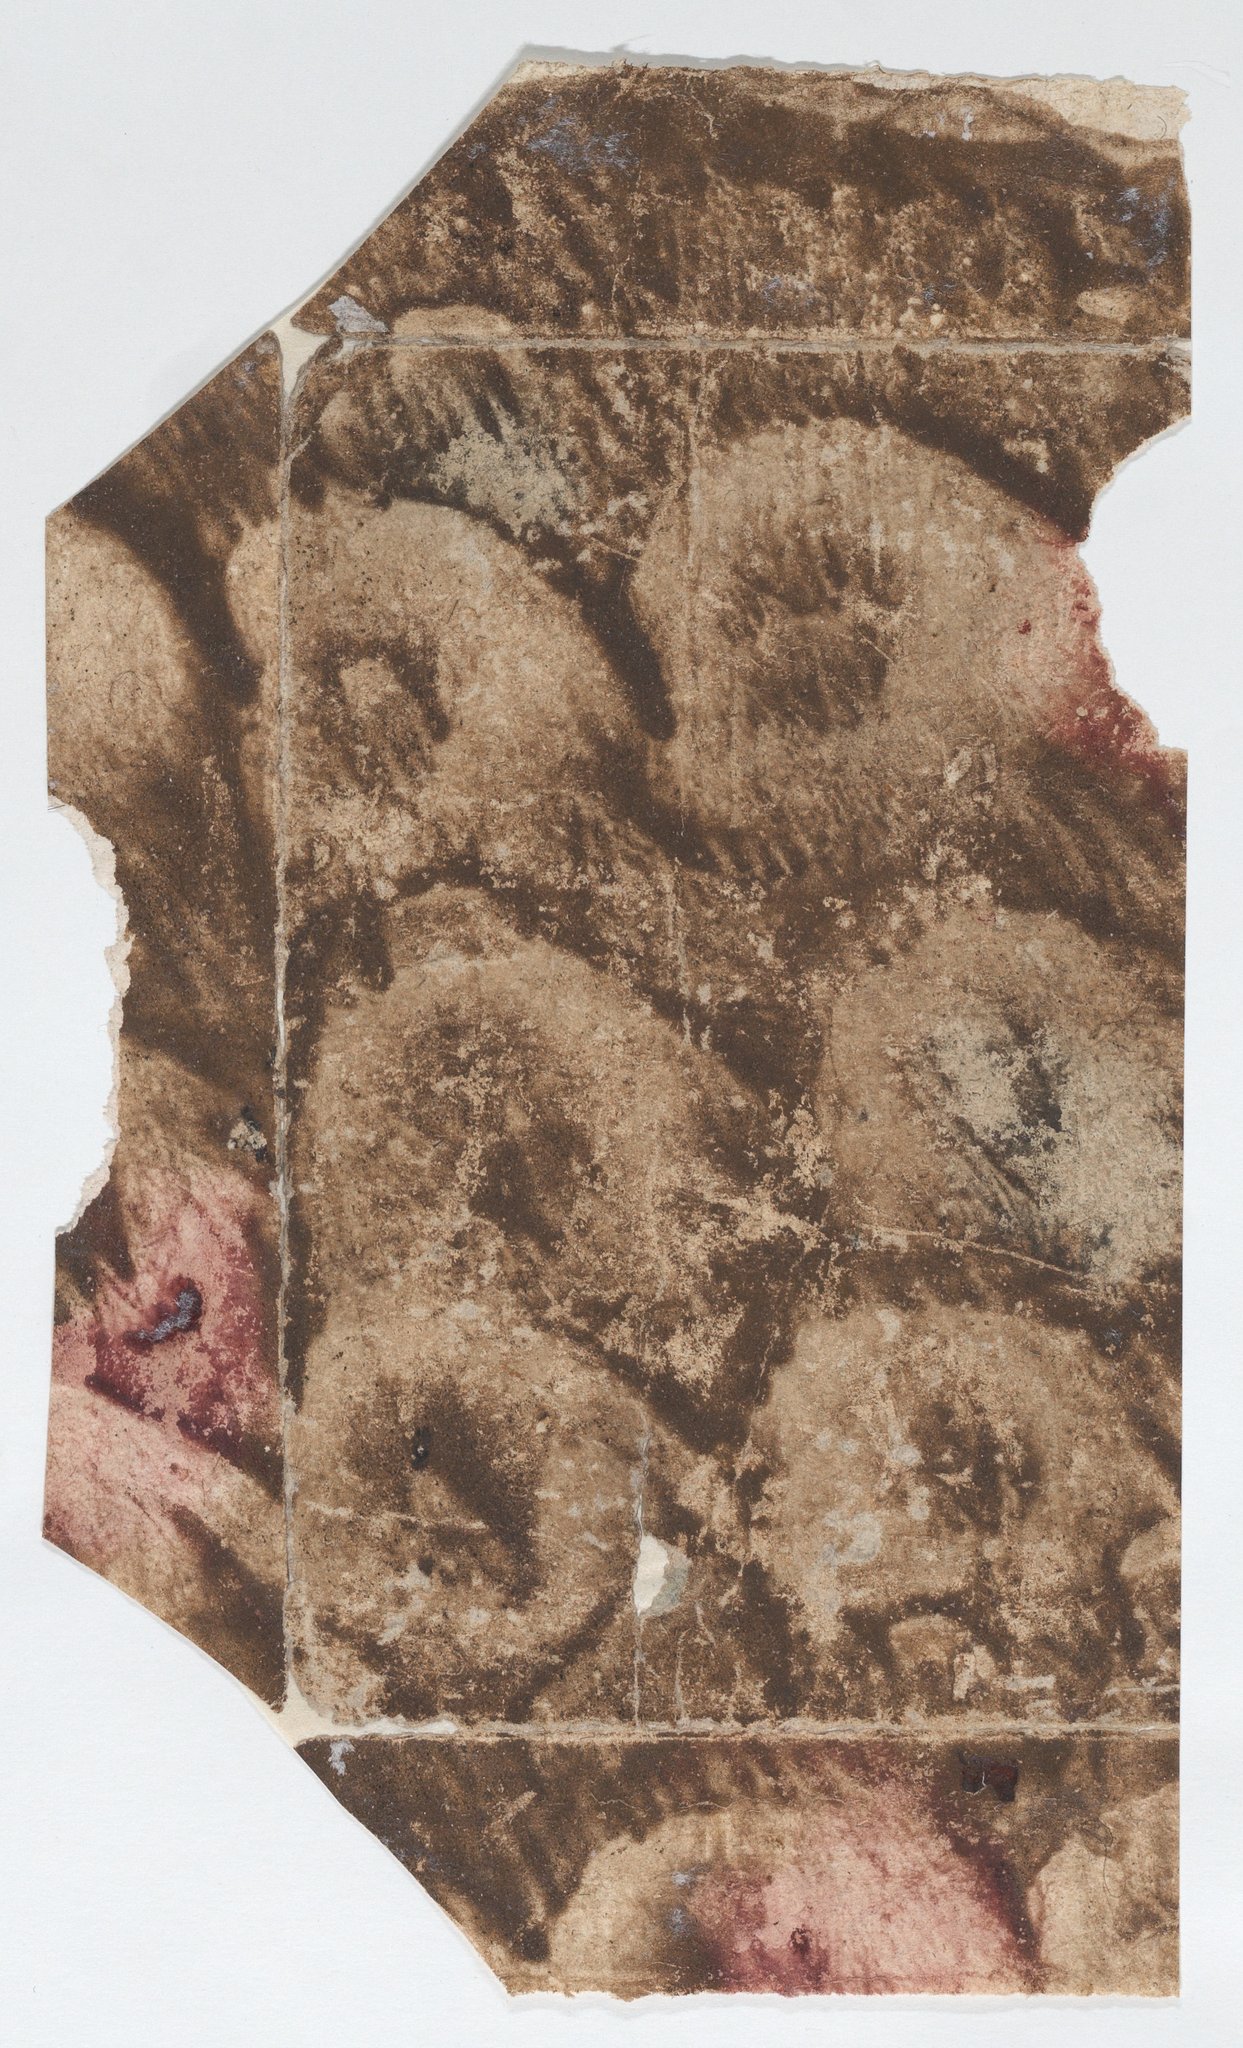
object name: print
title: Paste paper with brown pattern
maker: Anonymous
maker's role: artist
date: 1701-1800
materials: paper, paste